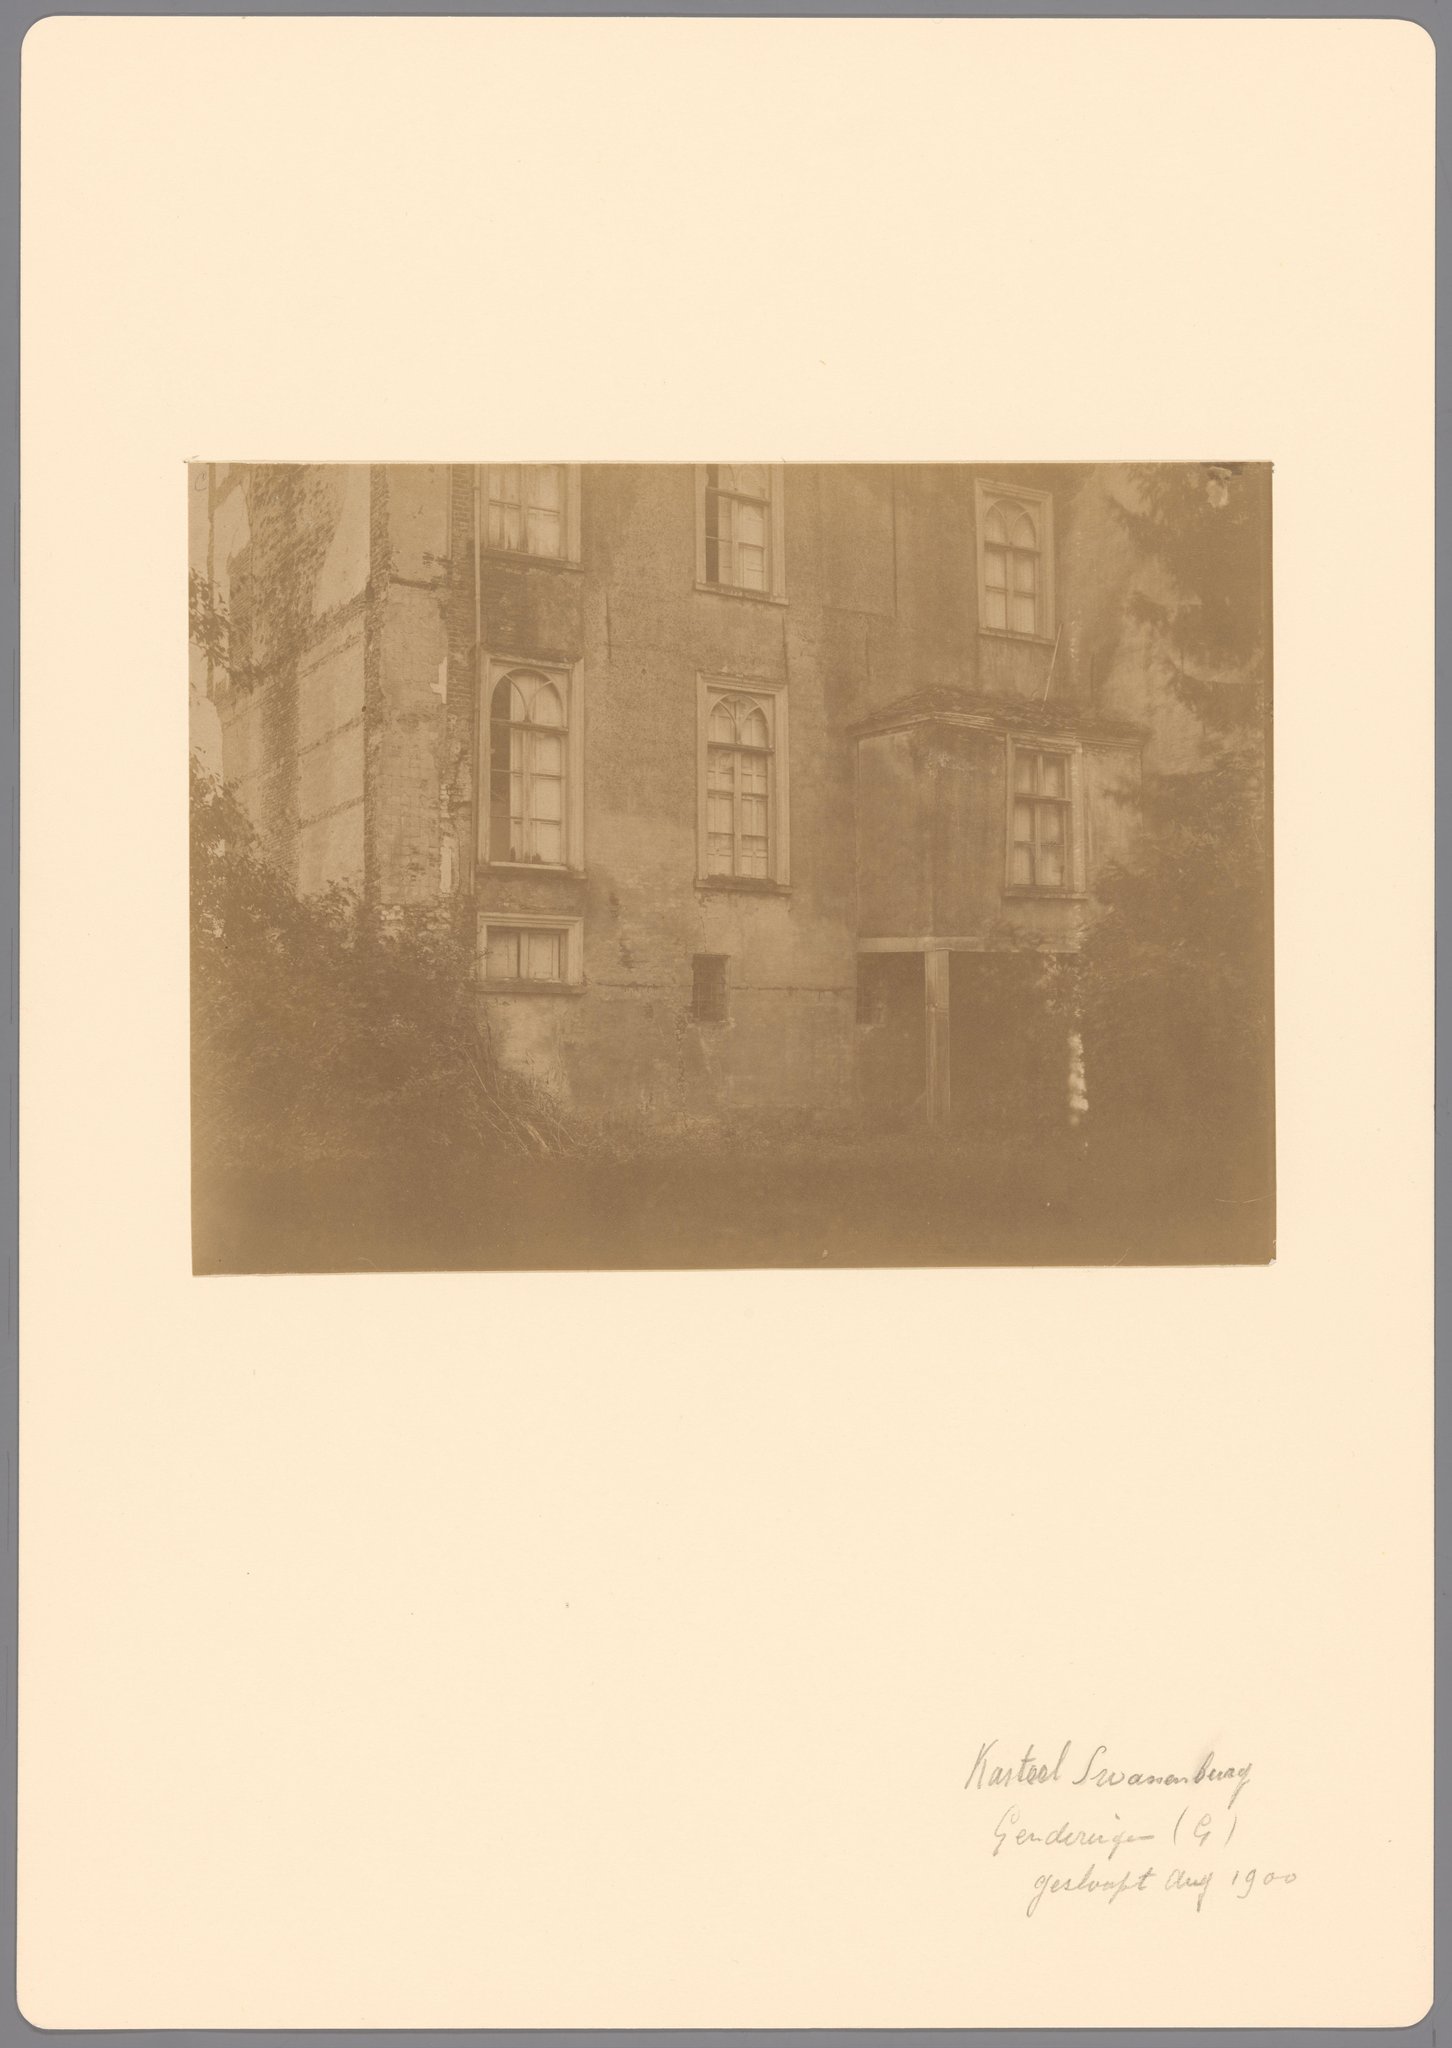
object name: photograph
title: Gedeelte van Kasteel Zwanenburg te Gendringen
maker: anoniem (monumentenzorg)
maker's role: fotograaf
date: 1890-1900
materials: cardboard, photographic support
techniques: albumen print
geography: gendringen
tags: castle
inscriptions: annotation: ‘c/ Kasteel Swanenburg/ Gendringen (G.)/ gesloopt aug 1900’